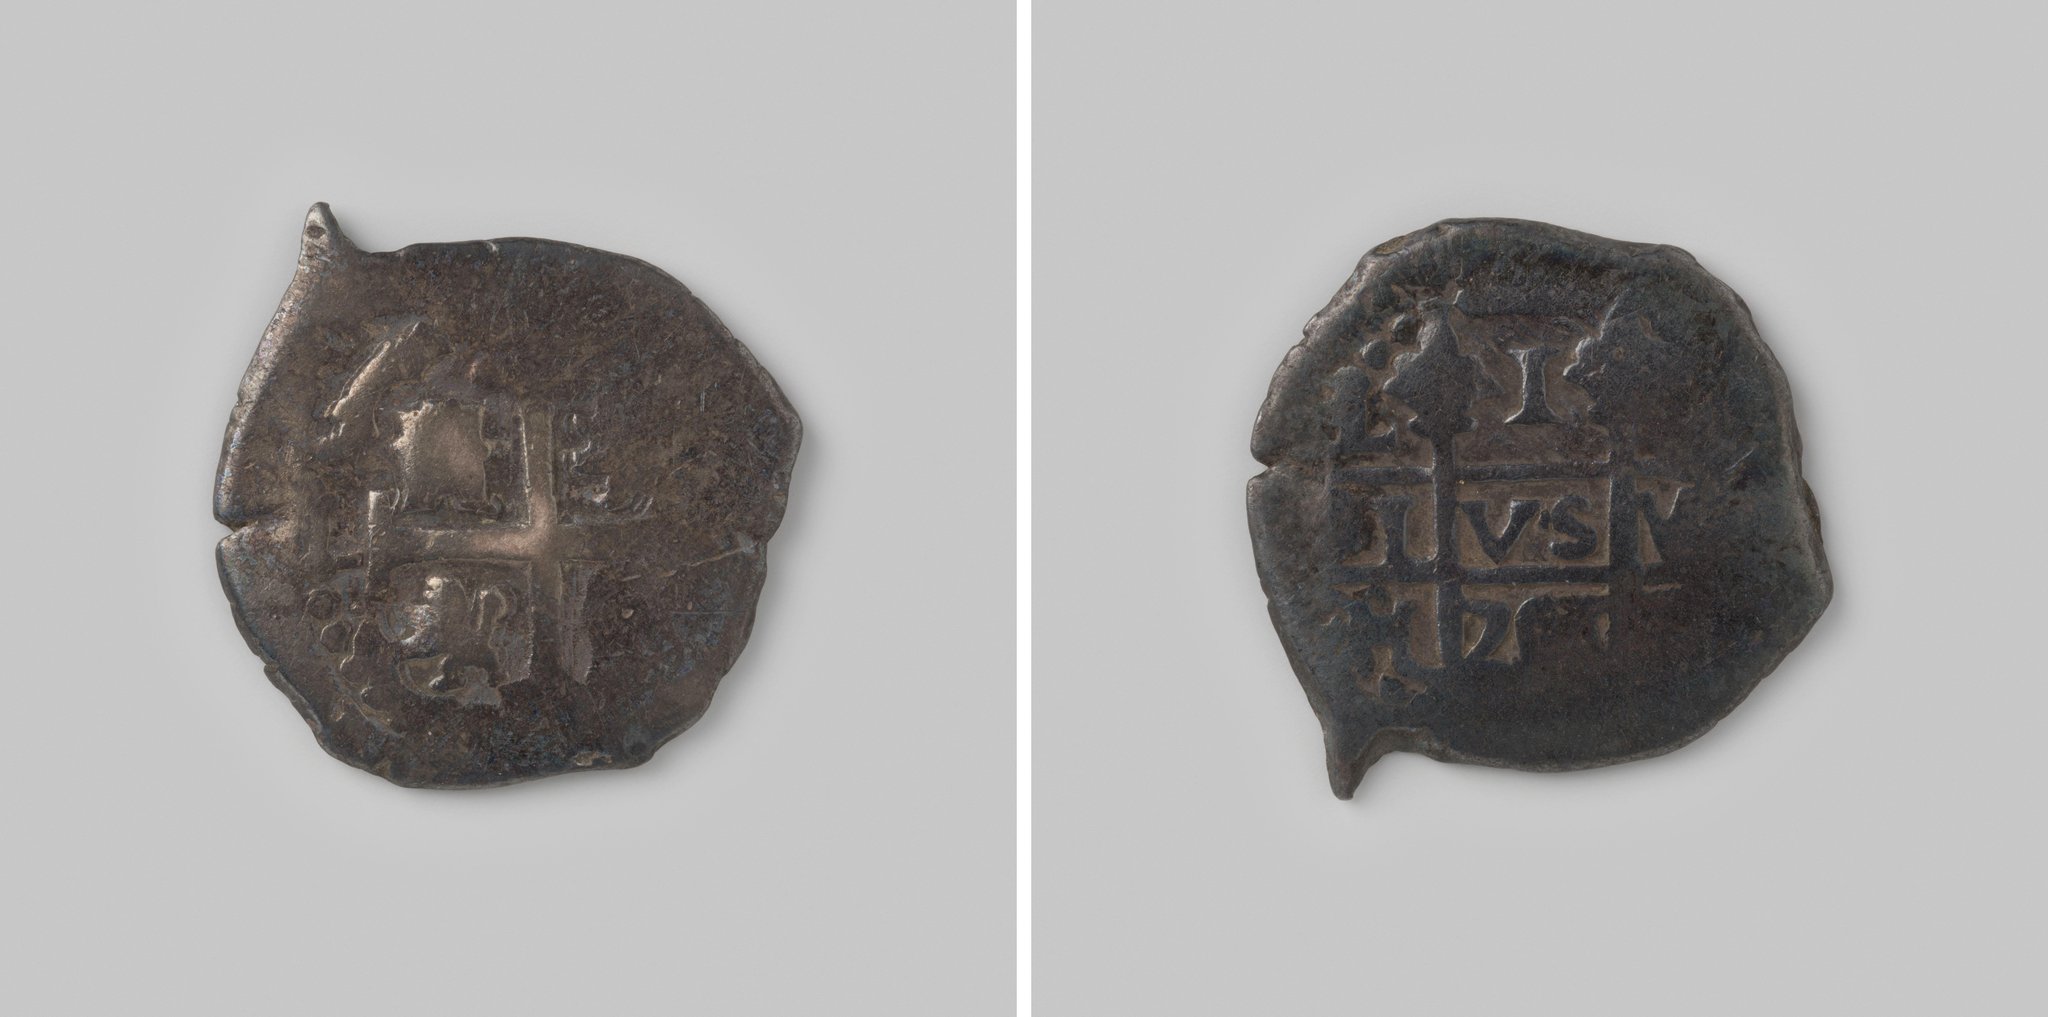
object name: coin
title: Reaal uit Peru van Philips V,1707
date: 1707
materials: silver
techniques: striking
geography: lima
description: Zilveren munt uit ruw muntplaatje. Voorzijde: binnen vierpas gelijkbenig herkruist kruis met in de hoeken afwisseld een kasteel en een leeuw. Keerzijde: tussen twee uit zee oprijzende zuilen, waarop versiering, in drie regels waarde-aanduiding: I, opschrift en jaartal: 707. Daartussen tweemaal muntplaats-aanduiding: LM [=Lima].